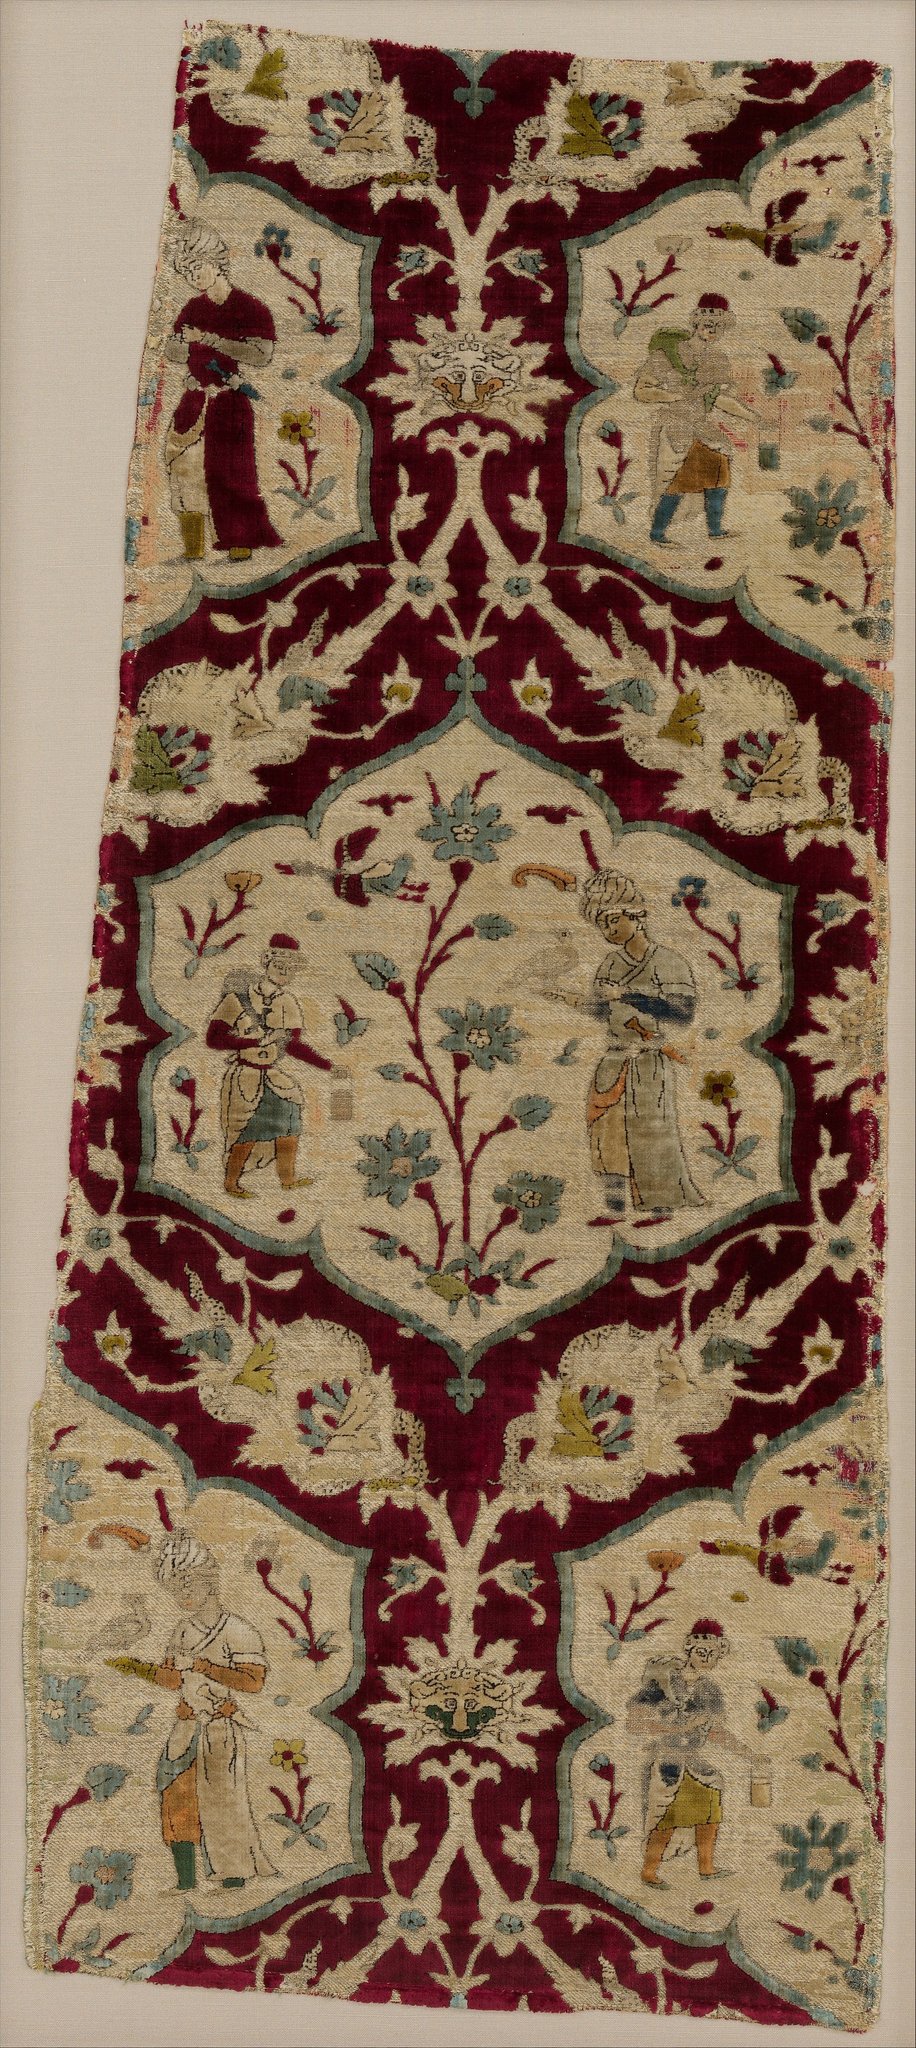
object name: textile fragment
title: Velvet with Figural Imagery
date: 1534-1566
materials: metal thread, silk, velvet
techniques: cutting, voiding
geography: iran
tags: birds,men,dragons,flowers